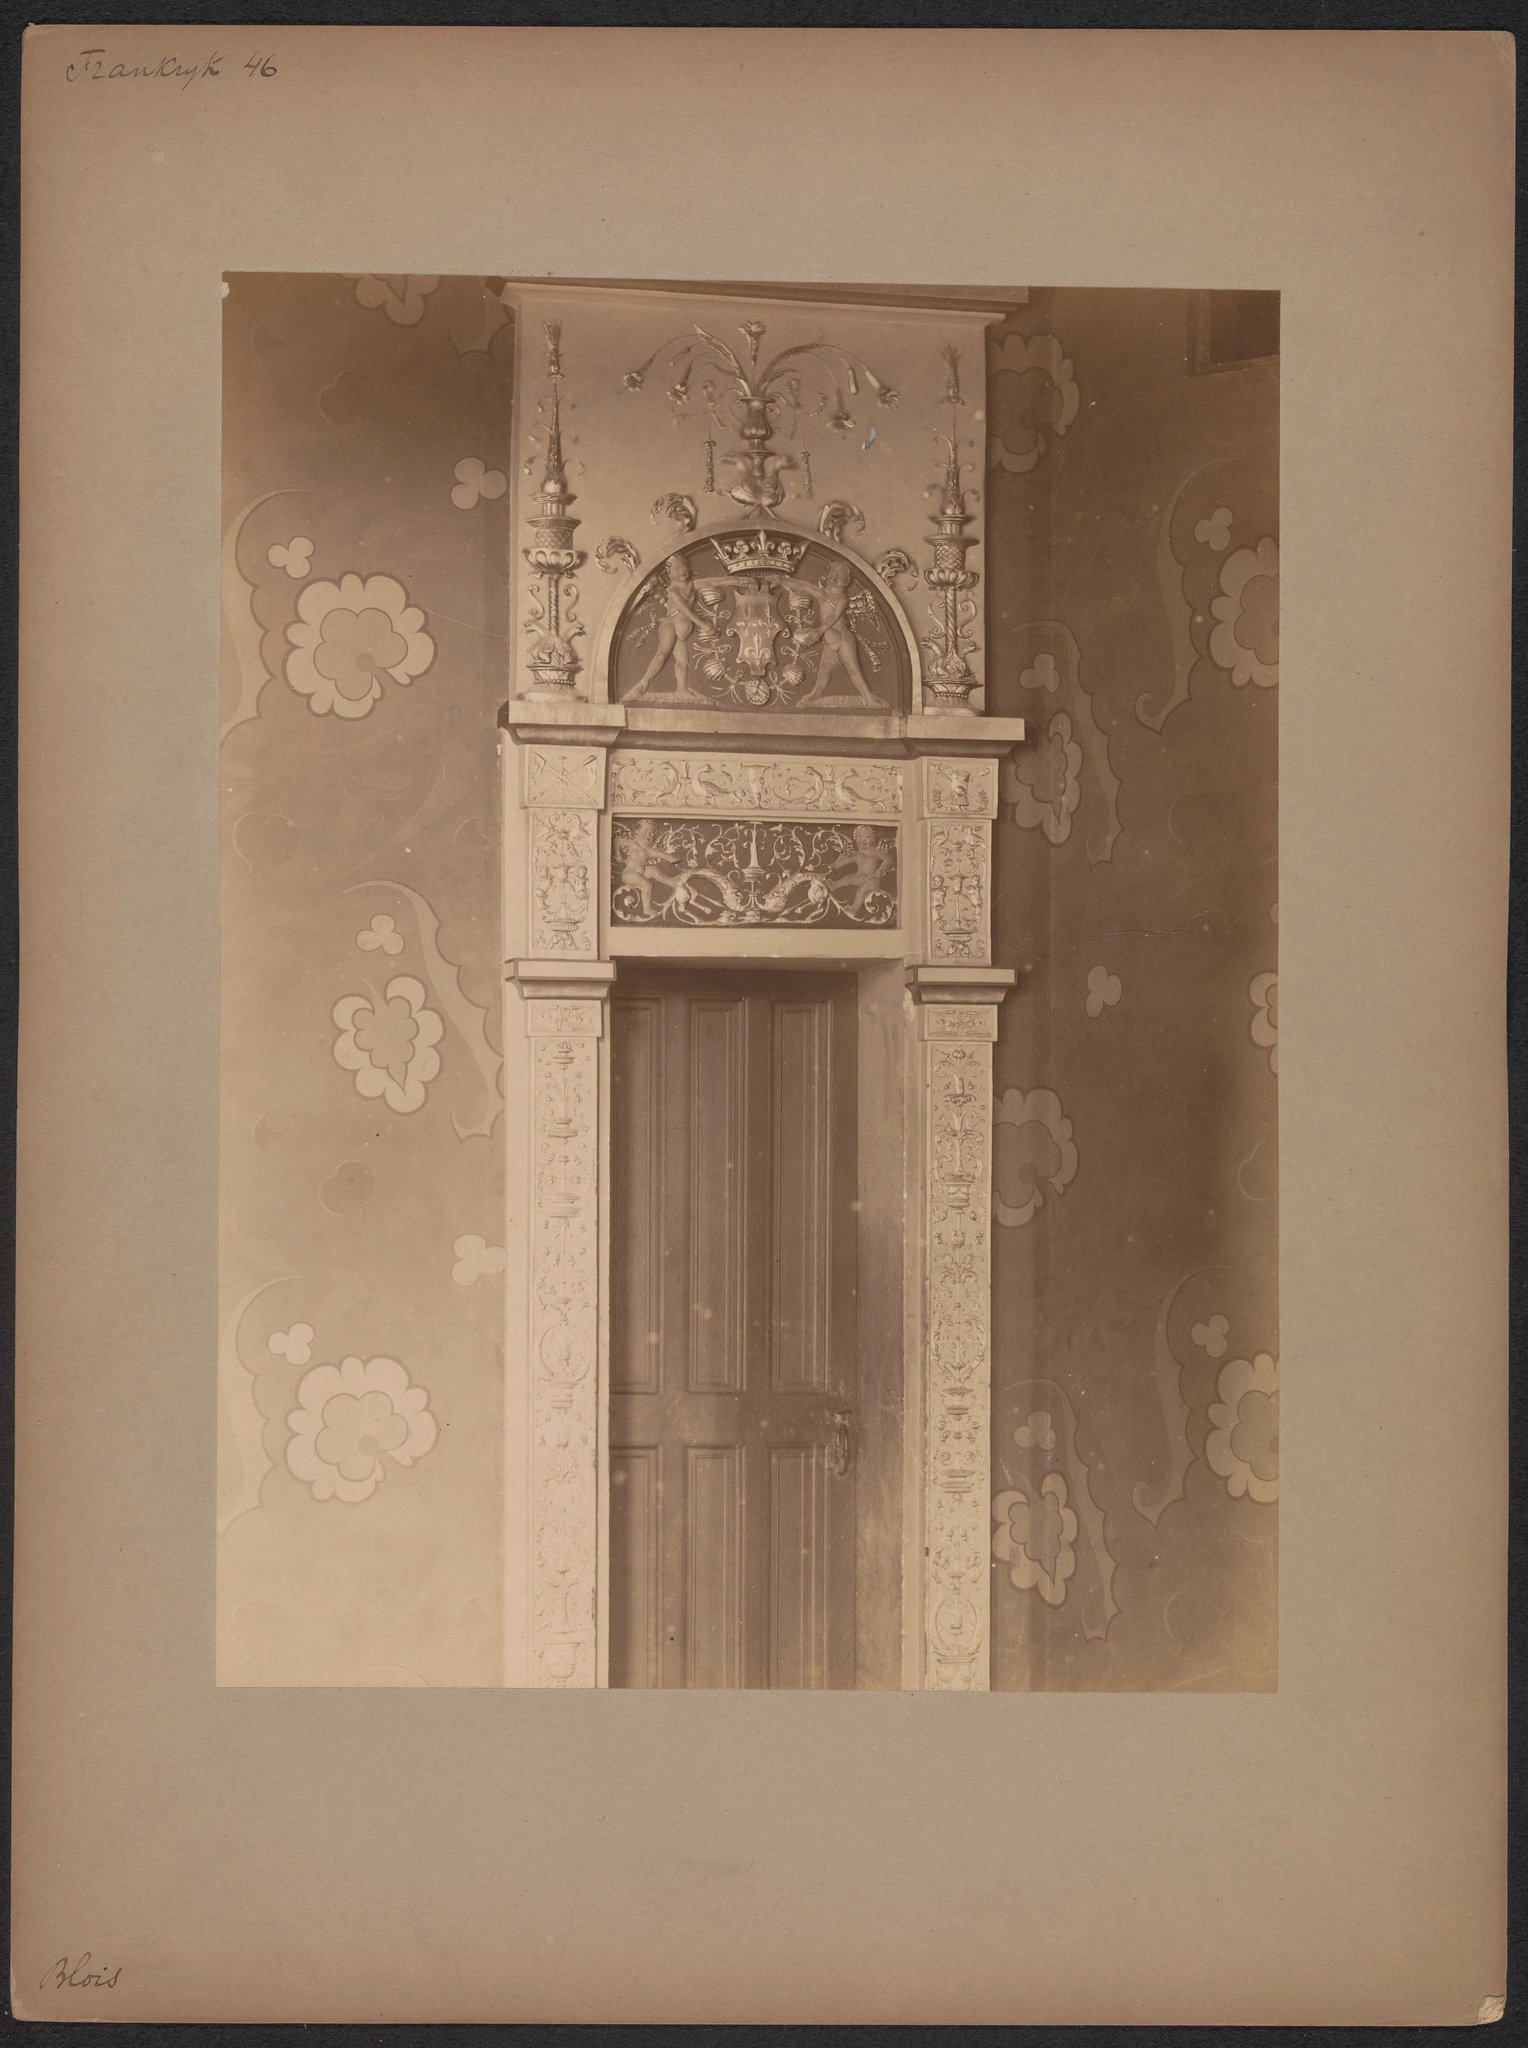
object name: photograph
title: Deur met gedecoreerde omlijsting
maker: Anonymous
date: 1850-1900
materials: cardboard, photographic support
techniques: albumen print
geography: blois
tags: door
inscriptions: annotation: ‘Blois’, annotation: ‘Blois.’, annotation: ‘Frankrijk 46’, collector's mark: ‘RIJKS [NORMA]ALSCHOOL voor T[EEKENONDERWIJZERS] AMSTERDAM’